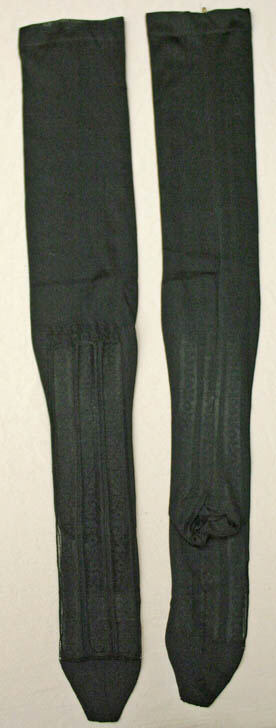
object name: stocking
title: Stockings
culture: french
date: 1801-1900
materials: silk